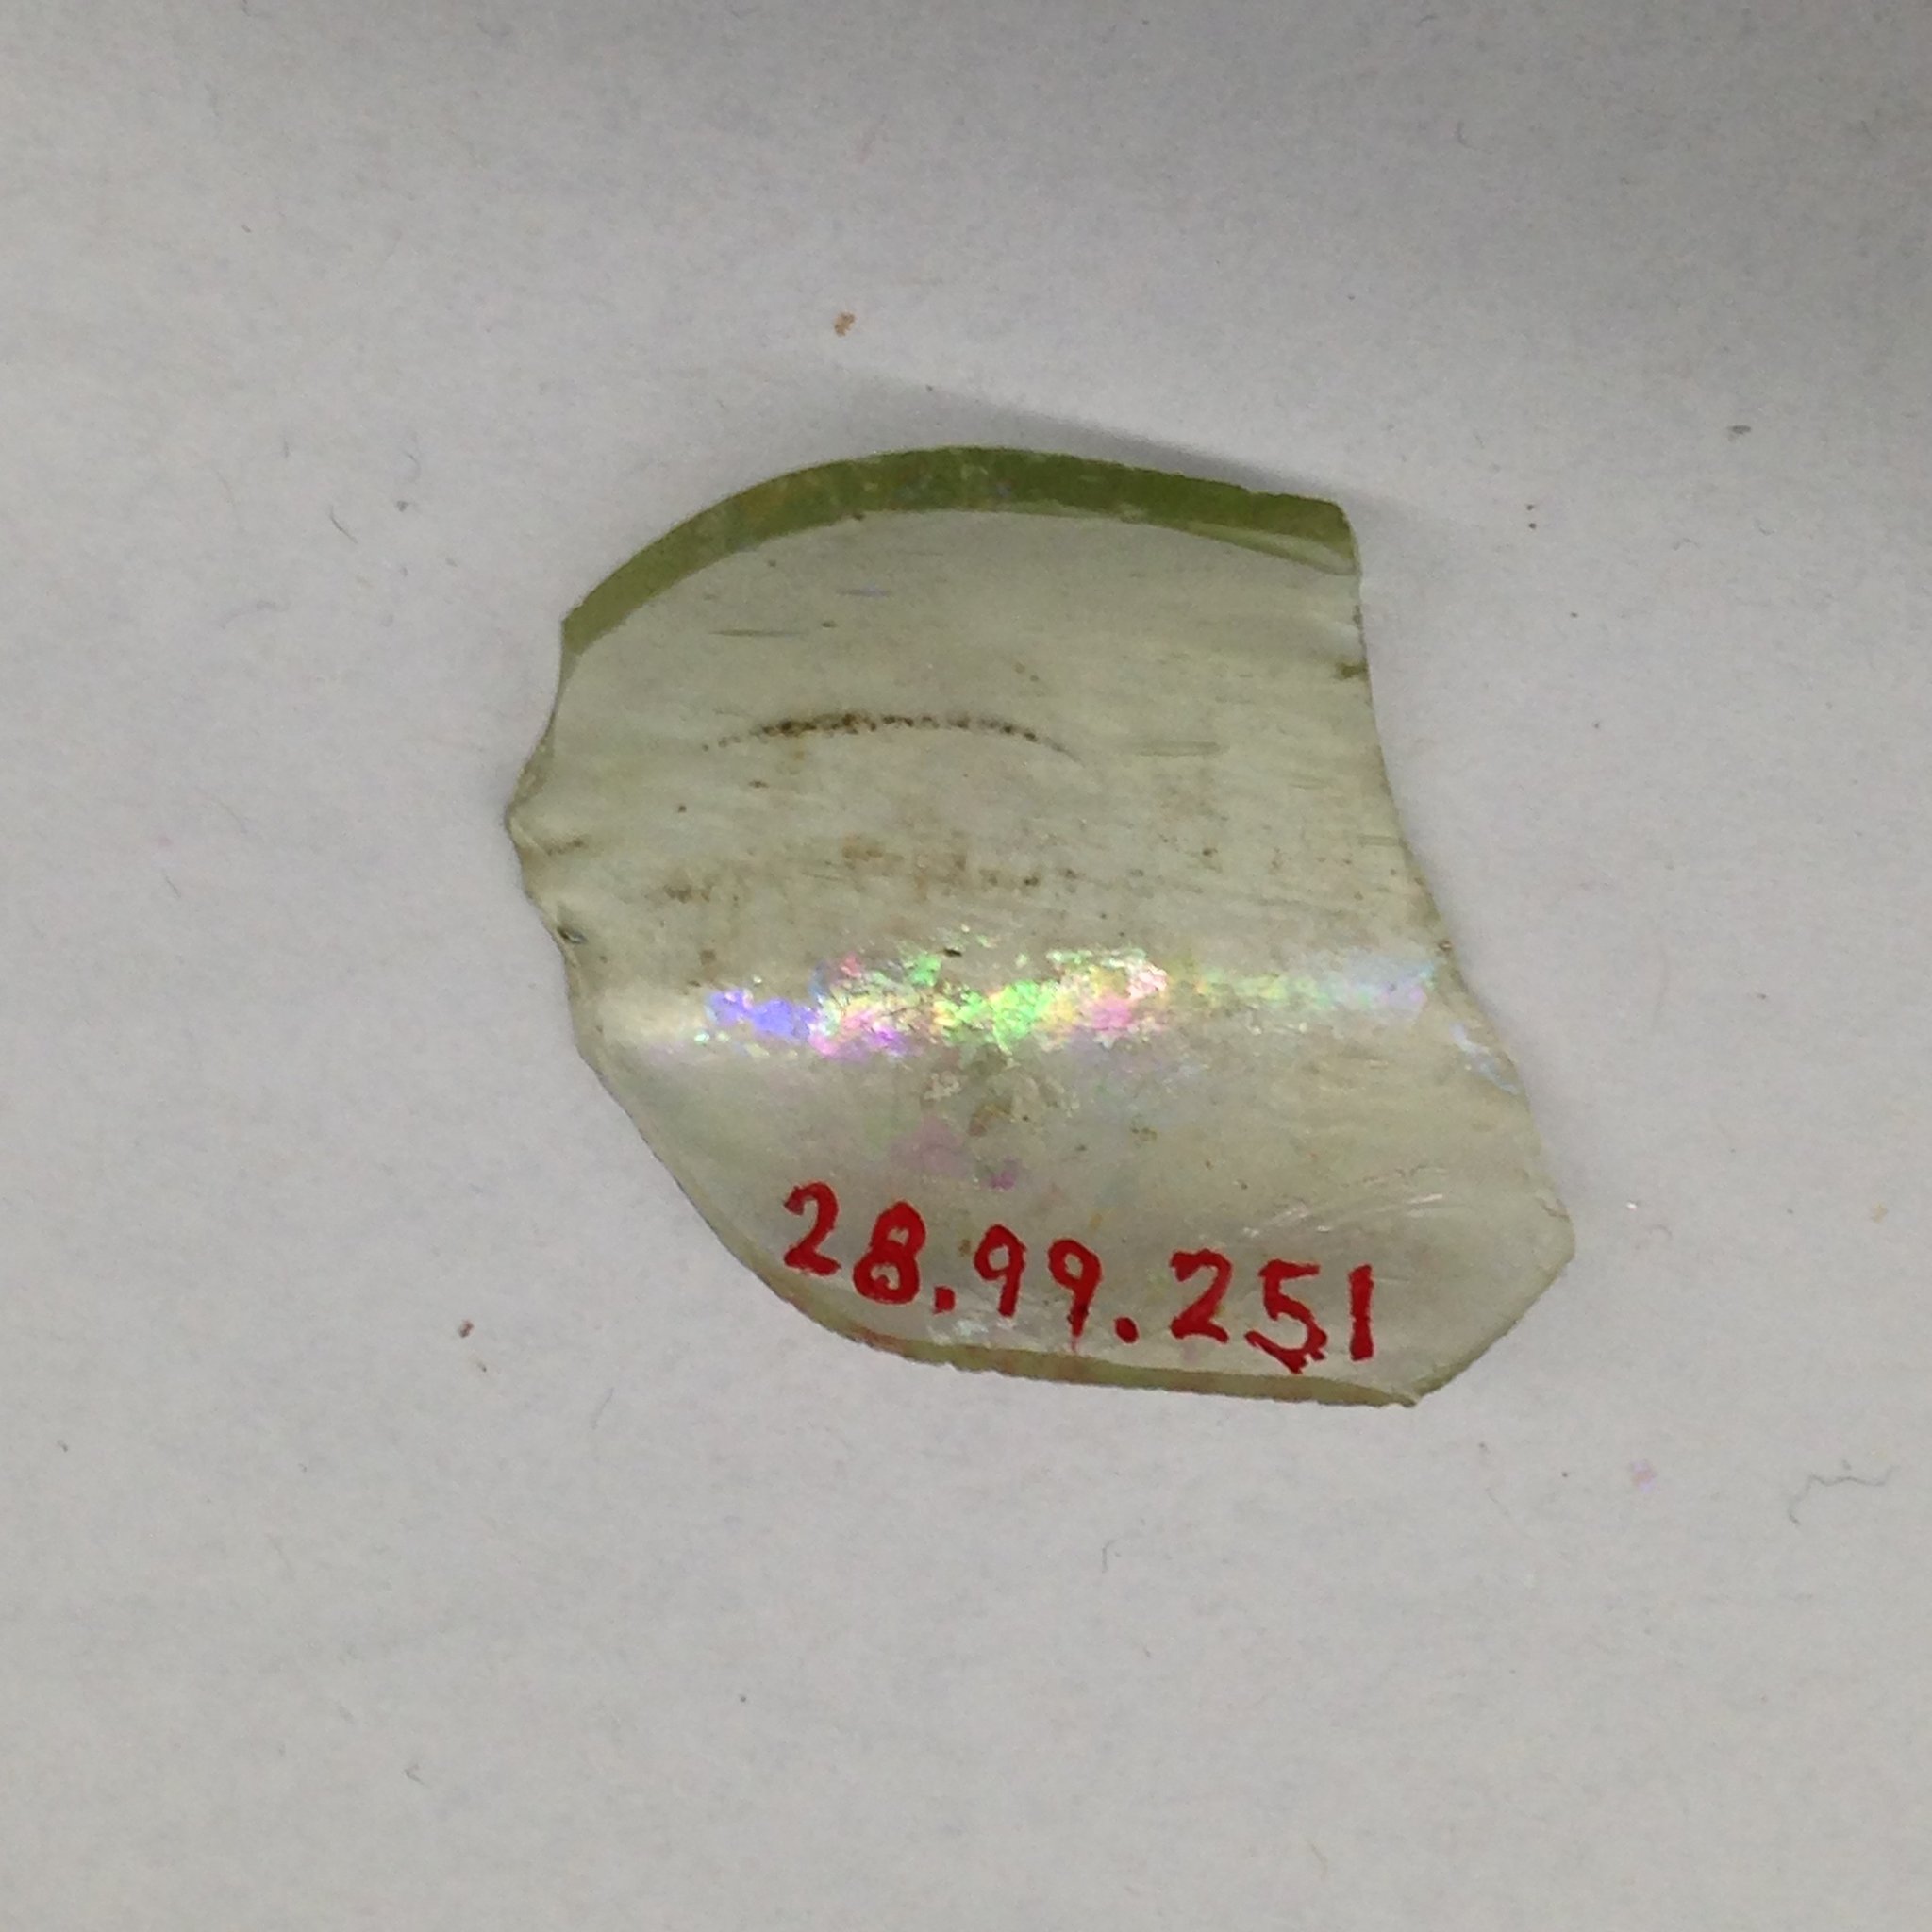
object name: fragment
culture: european or middle eastern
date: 1150-1250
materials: ceramic, glass